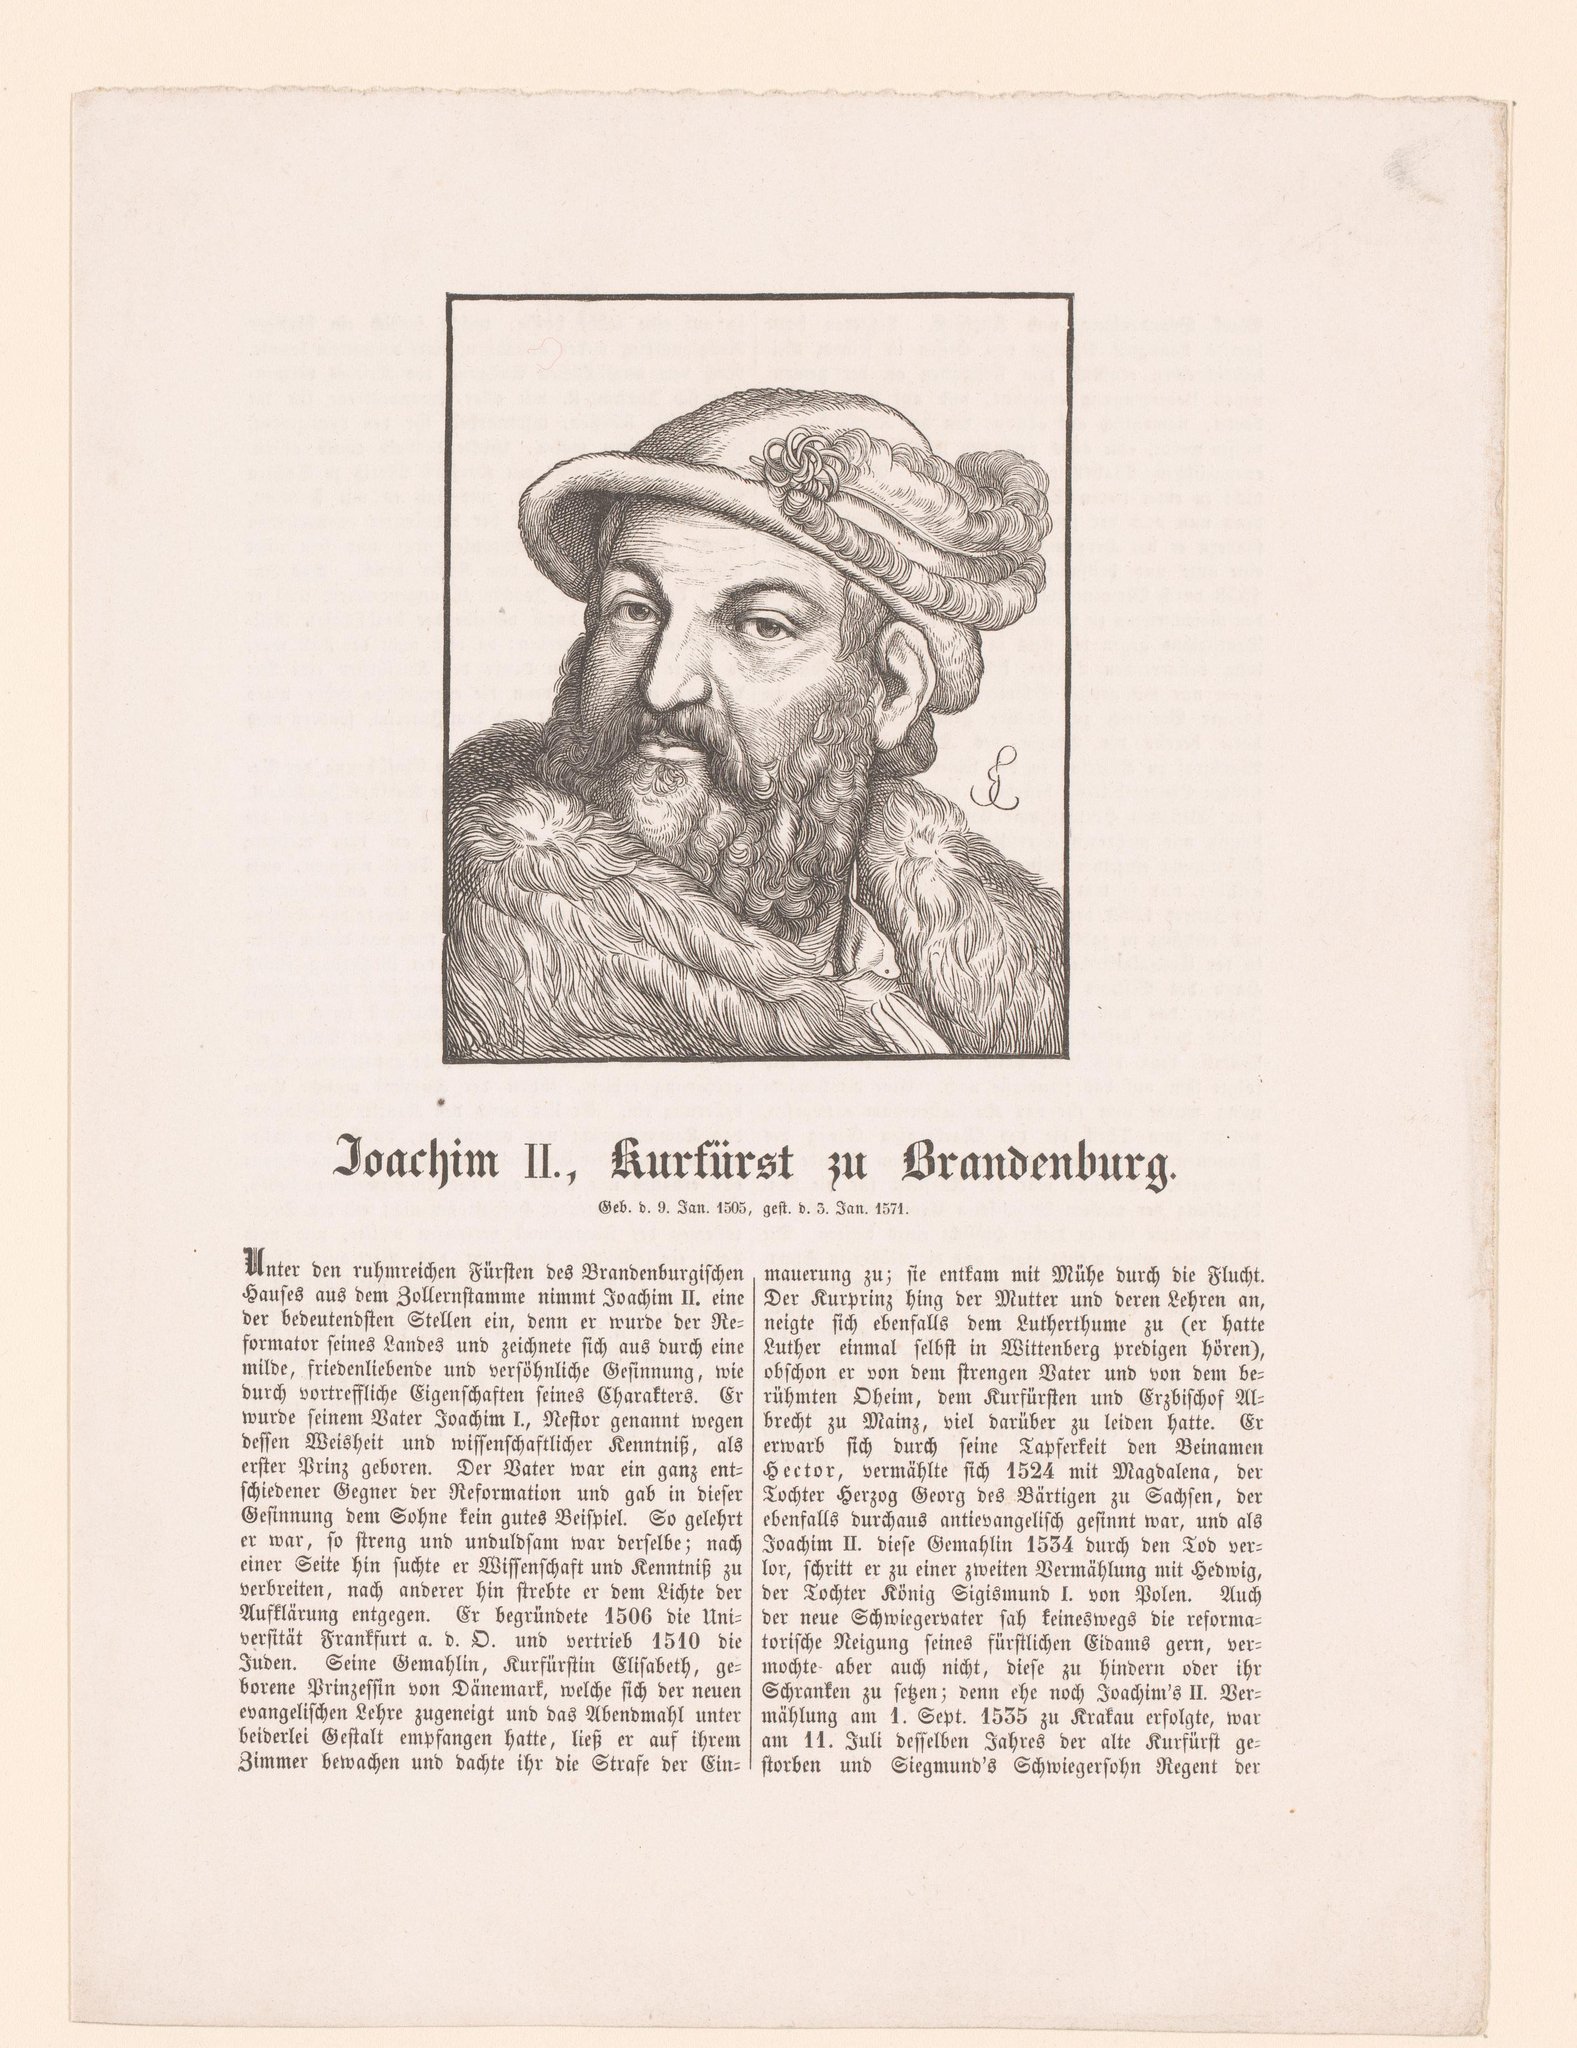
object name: book illustration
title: Portretten van Duitse vorsten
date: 1854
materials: paper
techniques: engraving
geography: leipzig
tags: historical persons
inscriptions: collector's mark: Lugt 2228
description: Bladzijde uit: Bechstein, Ludwig. Zweihundert deutsche Männer in Bildnissen und Lebensbeschreibungen. Leipzig: Georg Wigand, 1854. Prent met andere tekst gebruikt in: Gaedertz, Karl Theodor. Dreihundert Bildnisse und Lebensabrisse berühmter deutscher Männer. Leipzig: Georg Wigand, 1890. Bij de uitgave uit 1890 staat op de titelpagina vermeld dat de prenten zijn gemaakt door Hugo Bürkner.